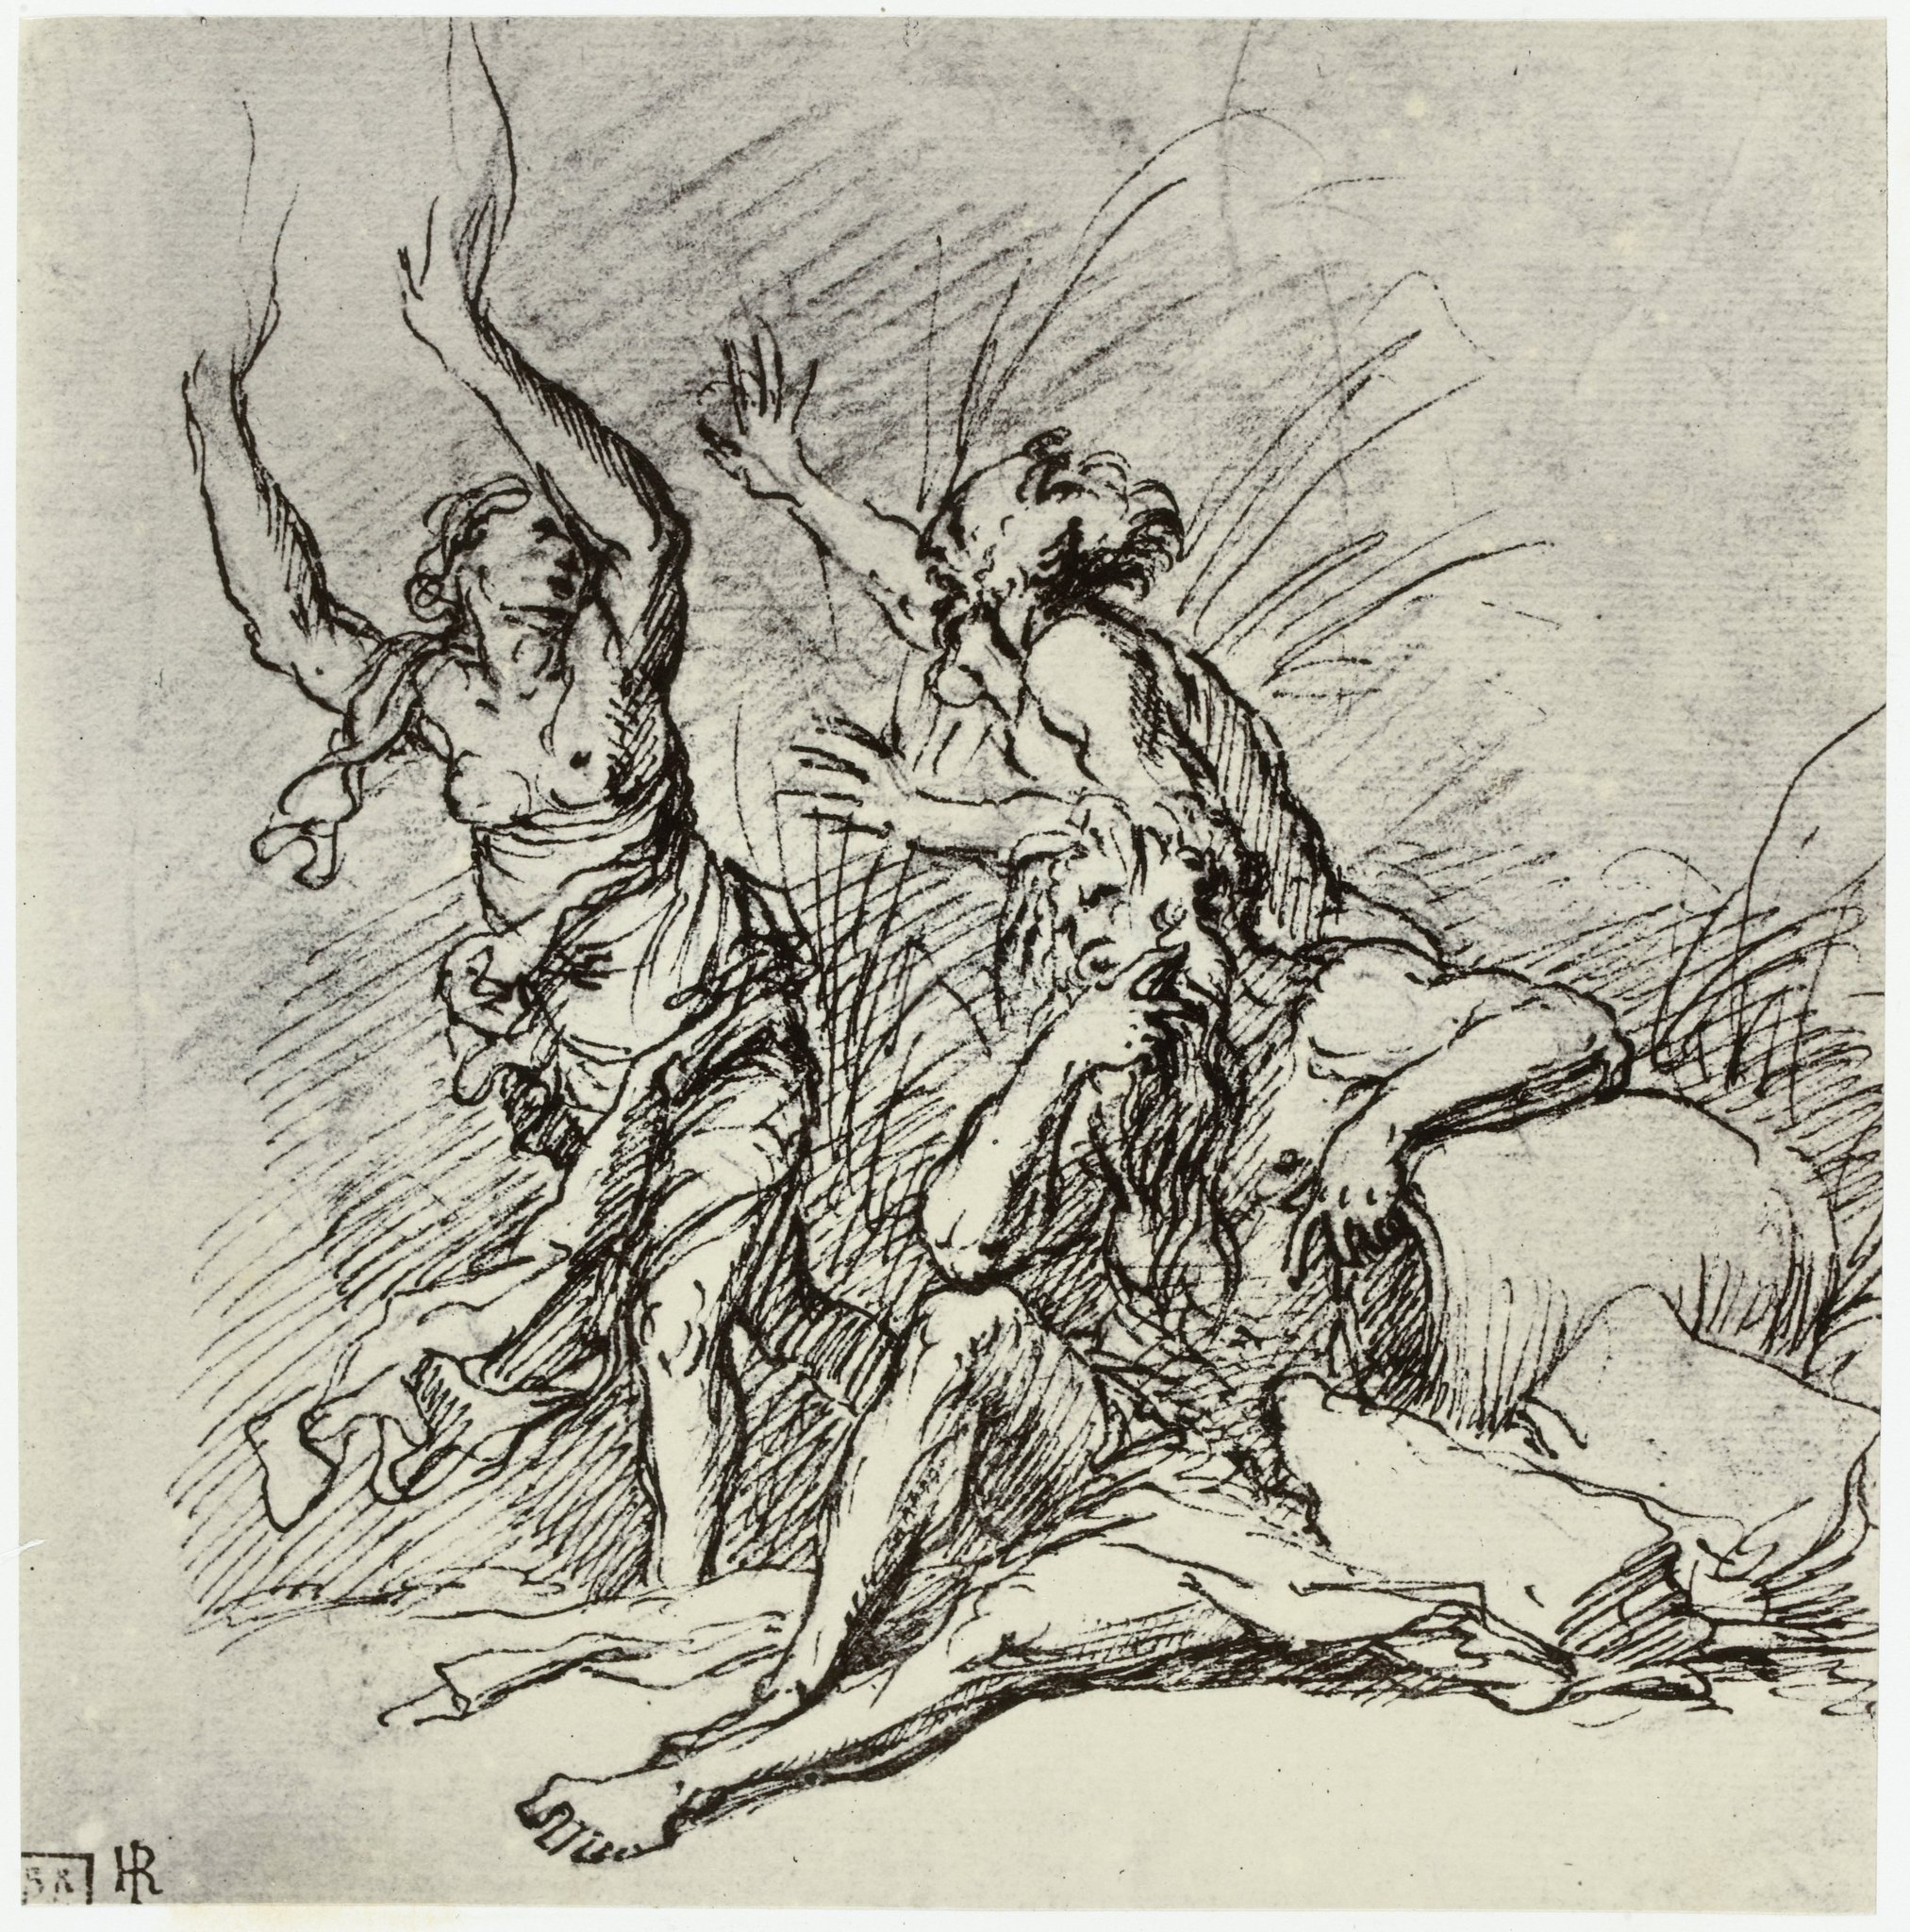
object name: photograph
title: Salvator Rosa, Pan and Syrinx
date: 1855-1858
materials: cardboard, paper, photographic support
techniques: albumen print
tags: drawing, sketch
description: Fotoreproductie van tekening in 'The Reveley Collection of Drawings at Brynygwin', afb. 41.